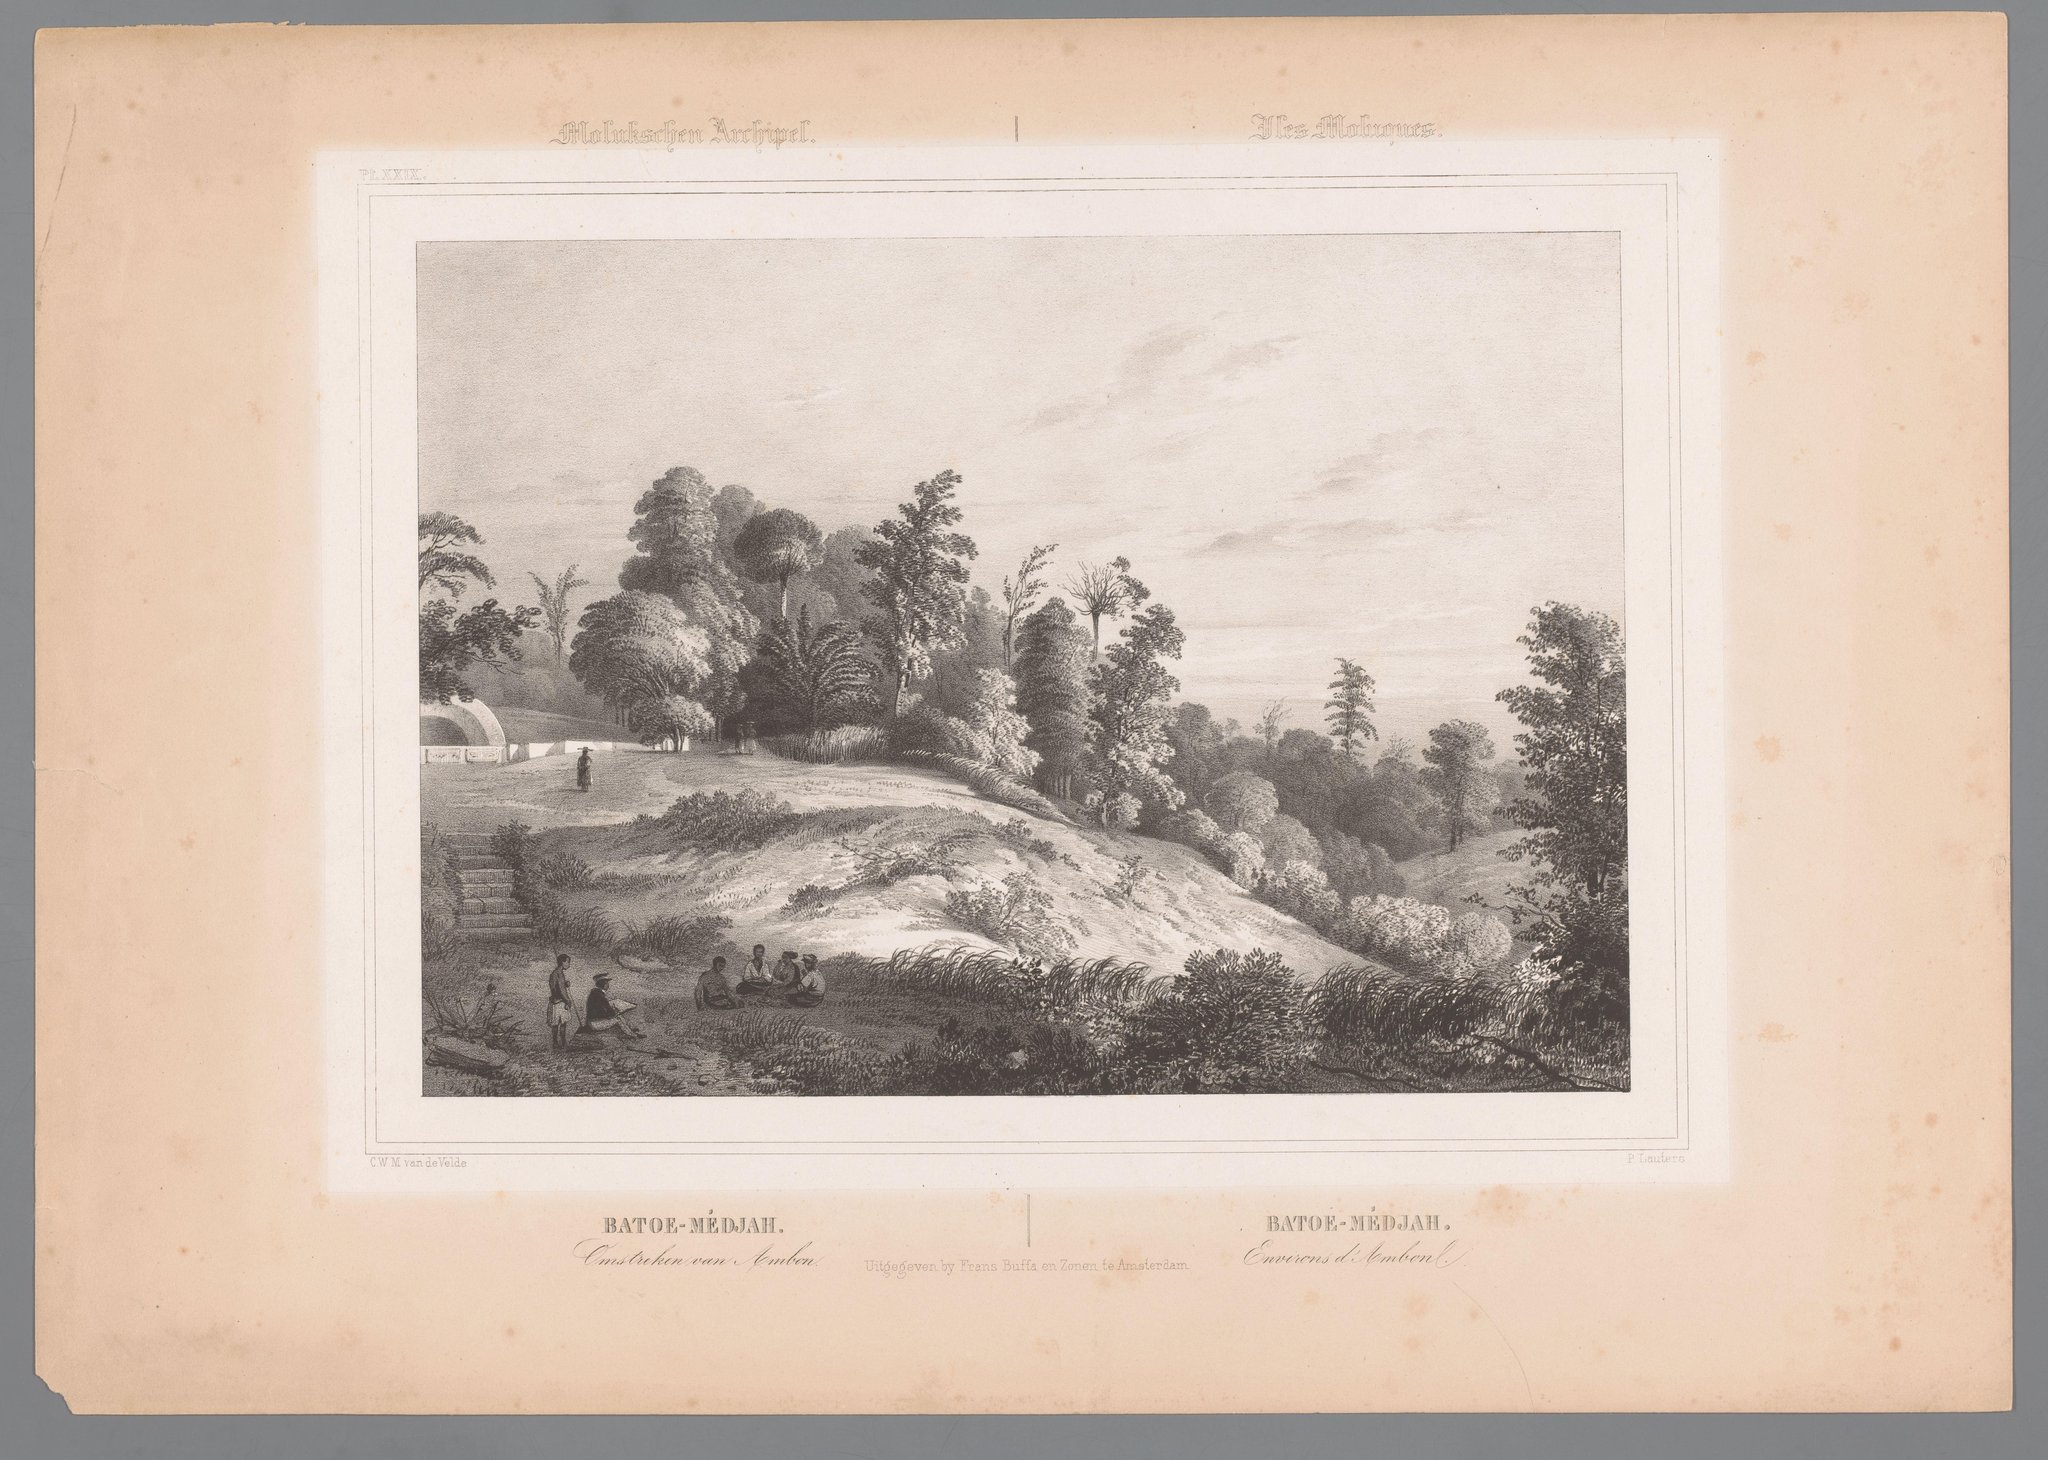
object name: print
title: Gezigten uit Neêrlands Indië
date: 1847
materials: paper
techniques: lithograph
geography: amsterdam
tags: low hill country (+ landscape with figures, staffage), landscapes in the non-temperate zone, exotic landscapes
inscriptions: label: ‘Koloniaal Instituut - Amsterdam; No. 15649A; Doos No. 157A. Onderwerp: Batoe-Medjah. Amboina. Afkomst: Kol. Mus. Haarlem.’, stamp: ‘Koloniaal Museum Haarlem’, inscription: ‘22; 2487-1909’, collector's mark: Lugt 2228